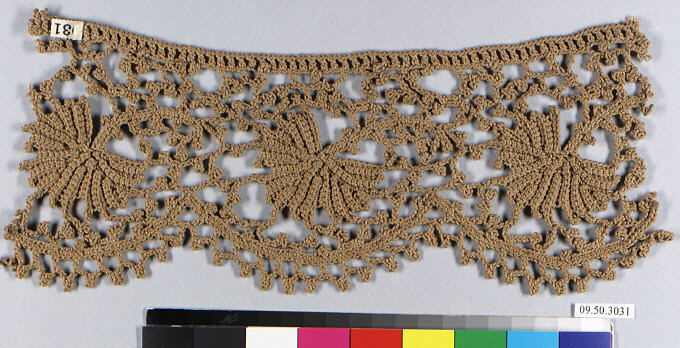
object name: sample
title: Crochet Work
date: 1801-1900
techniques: crochet